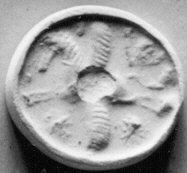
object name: stamp seal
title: Stamp seal (scaraboid) with monster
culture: assyrian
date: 734-601 BCE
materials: limestone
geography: northern syria or eastern anatolia